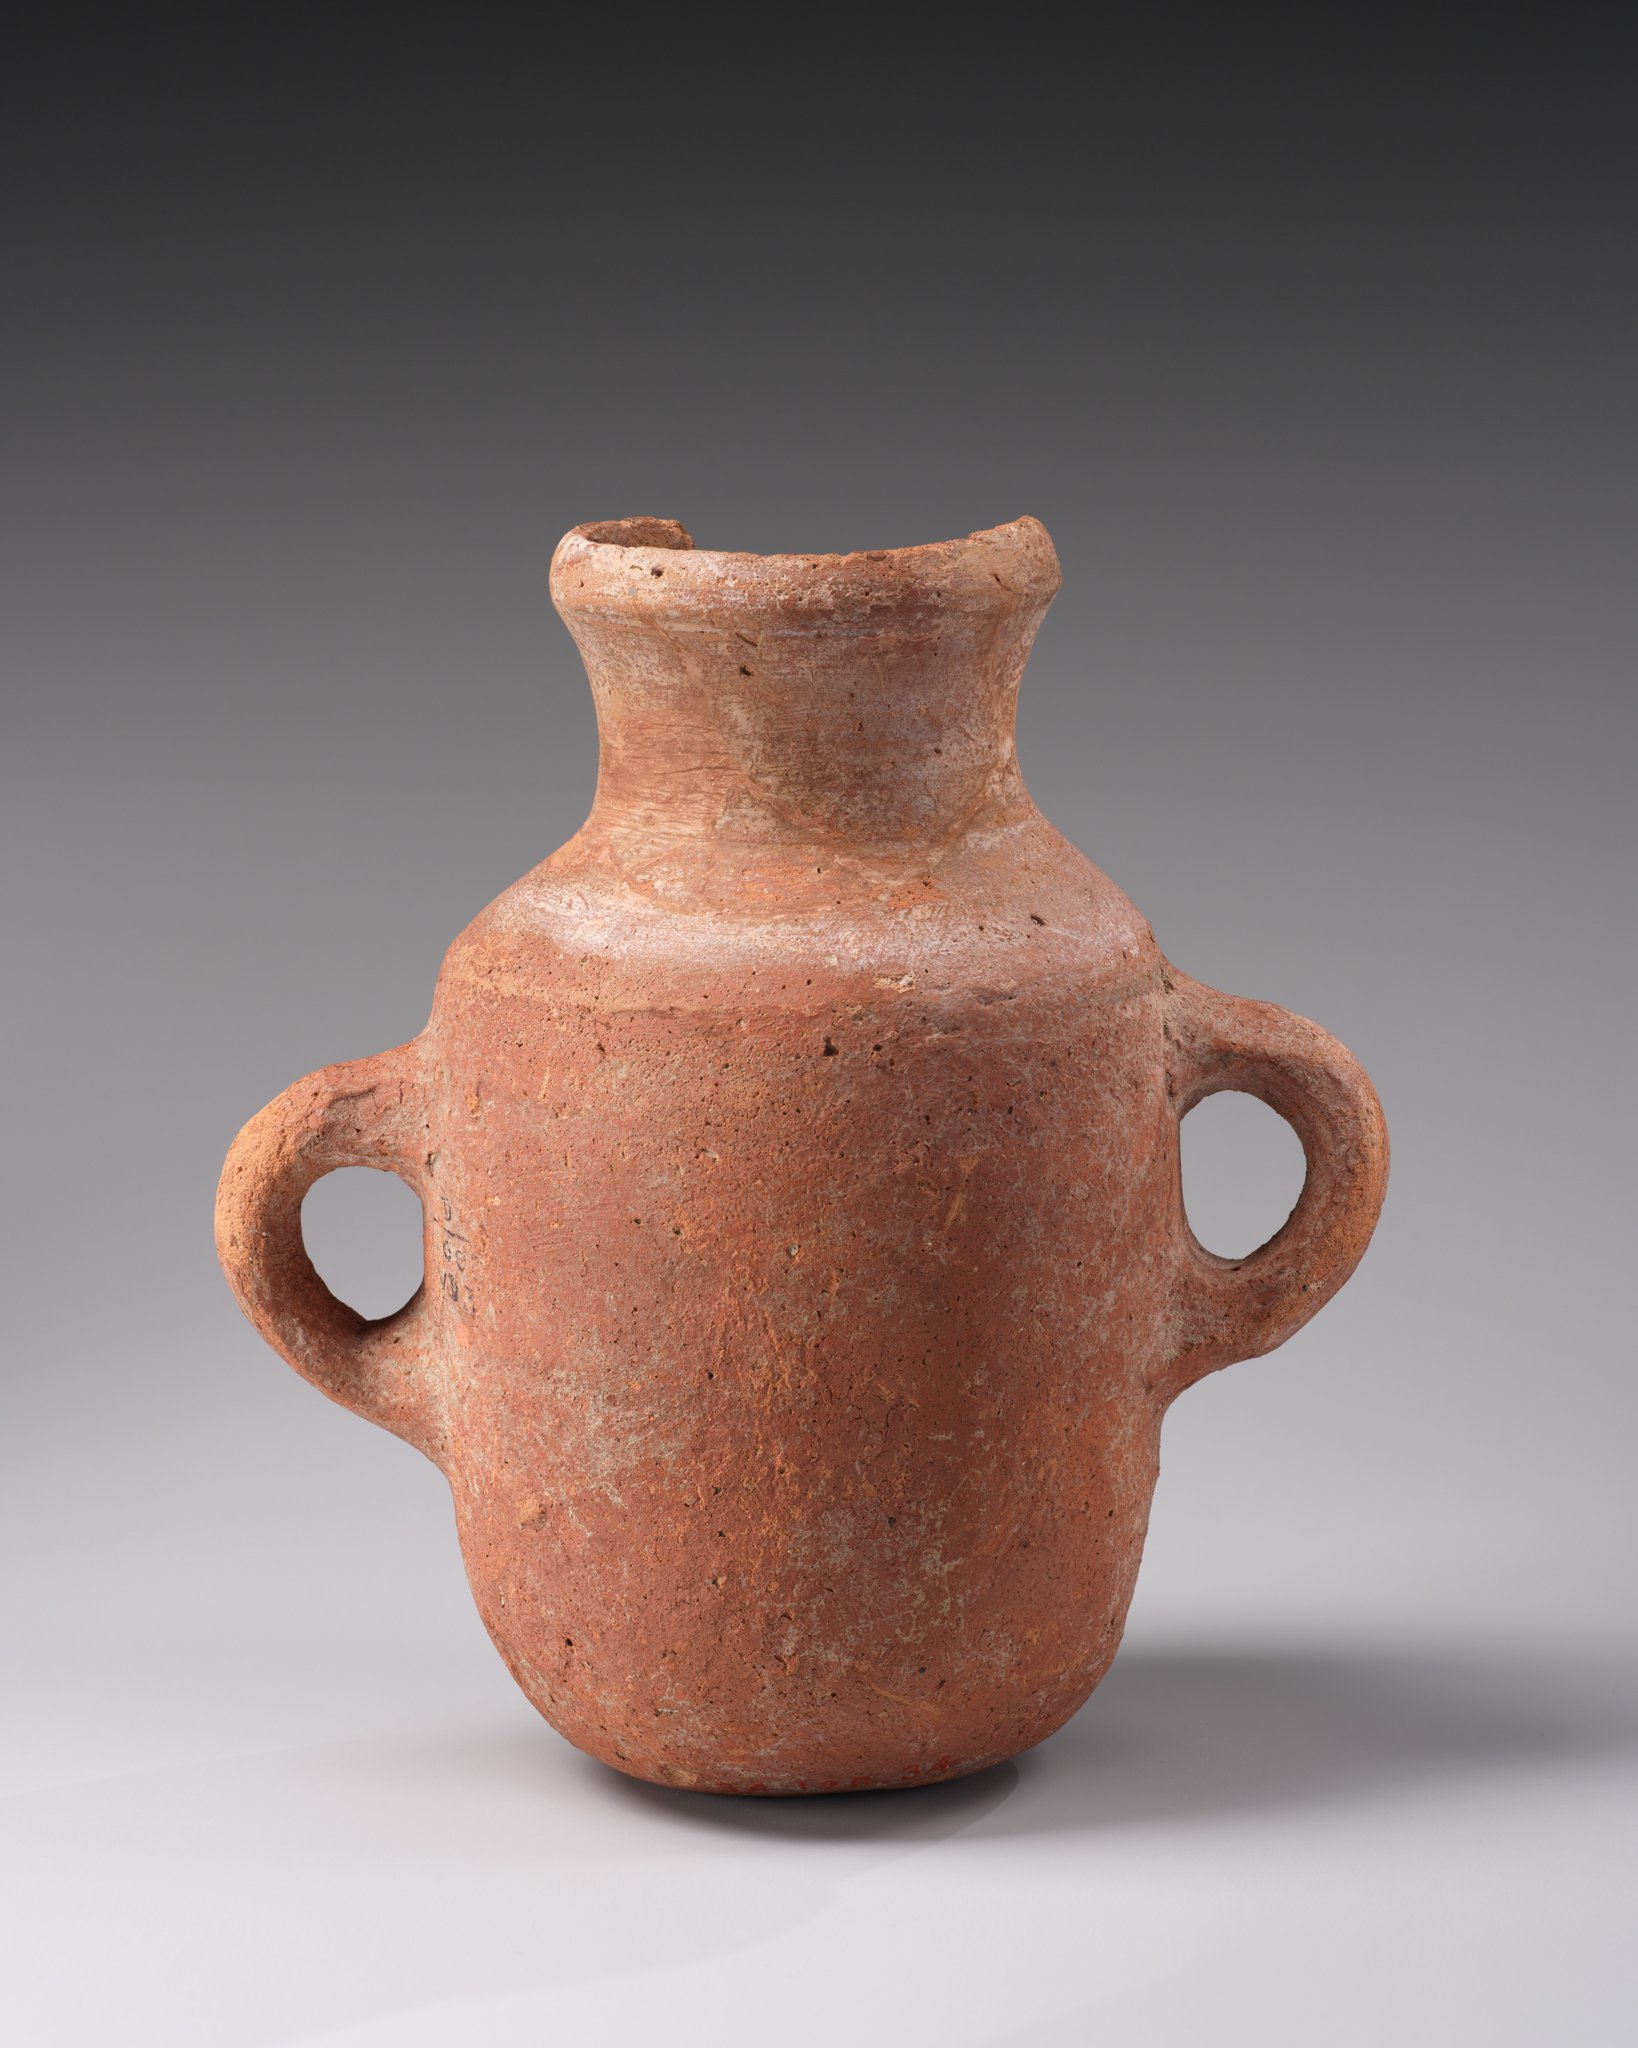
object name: bottle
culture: israelite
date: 734-601 BCE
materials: ceramic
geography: levant